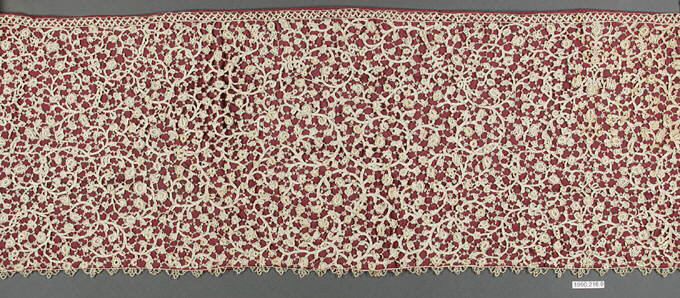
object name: border or flounce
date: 1601-1700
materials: linen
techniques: lace